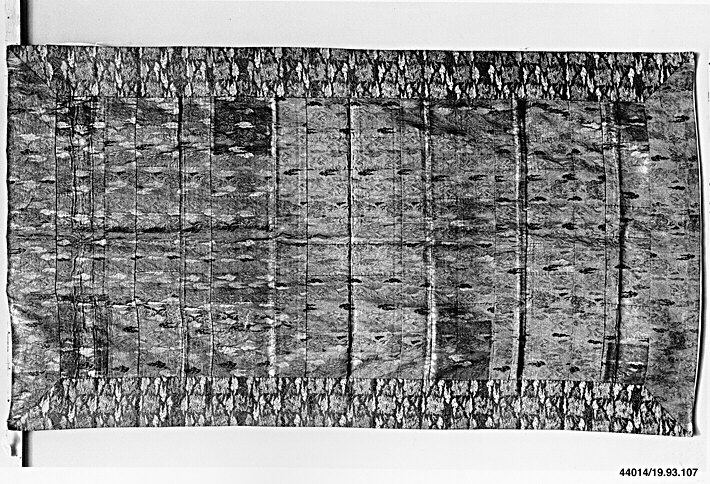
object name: robe, priest's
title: Priest's Robe (Shichijō)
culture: japanese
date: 1700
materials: metal thread, silk